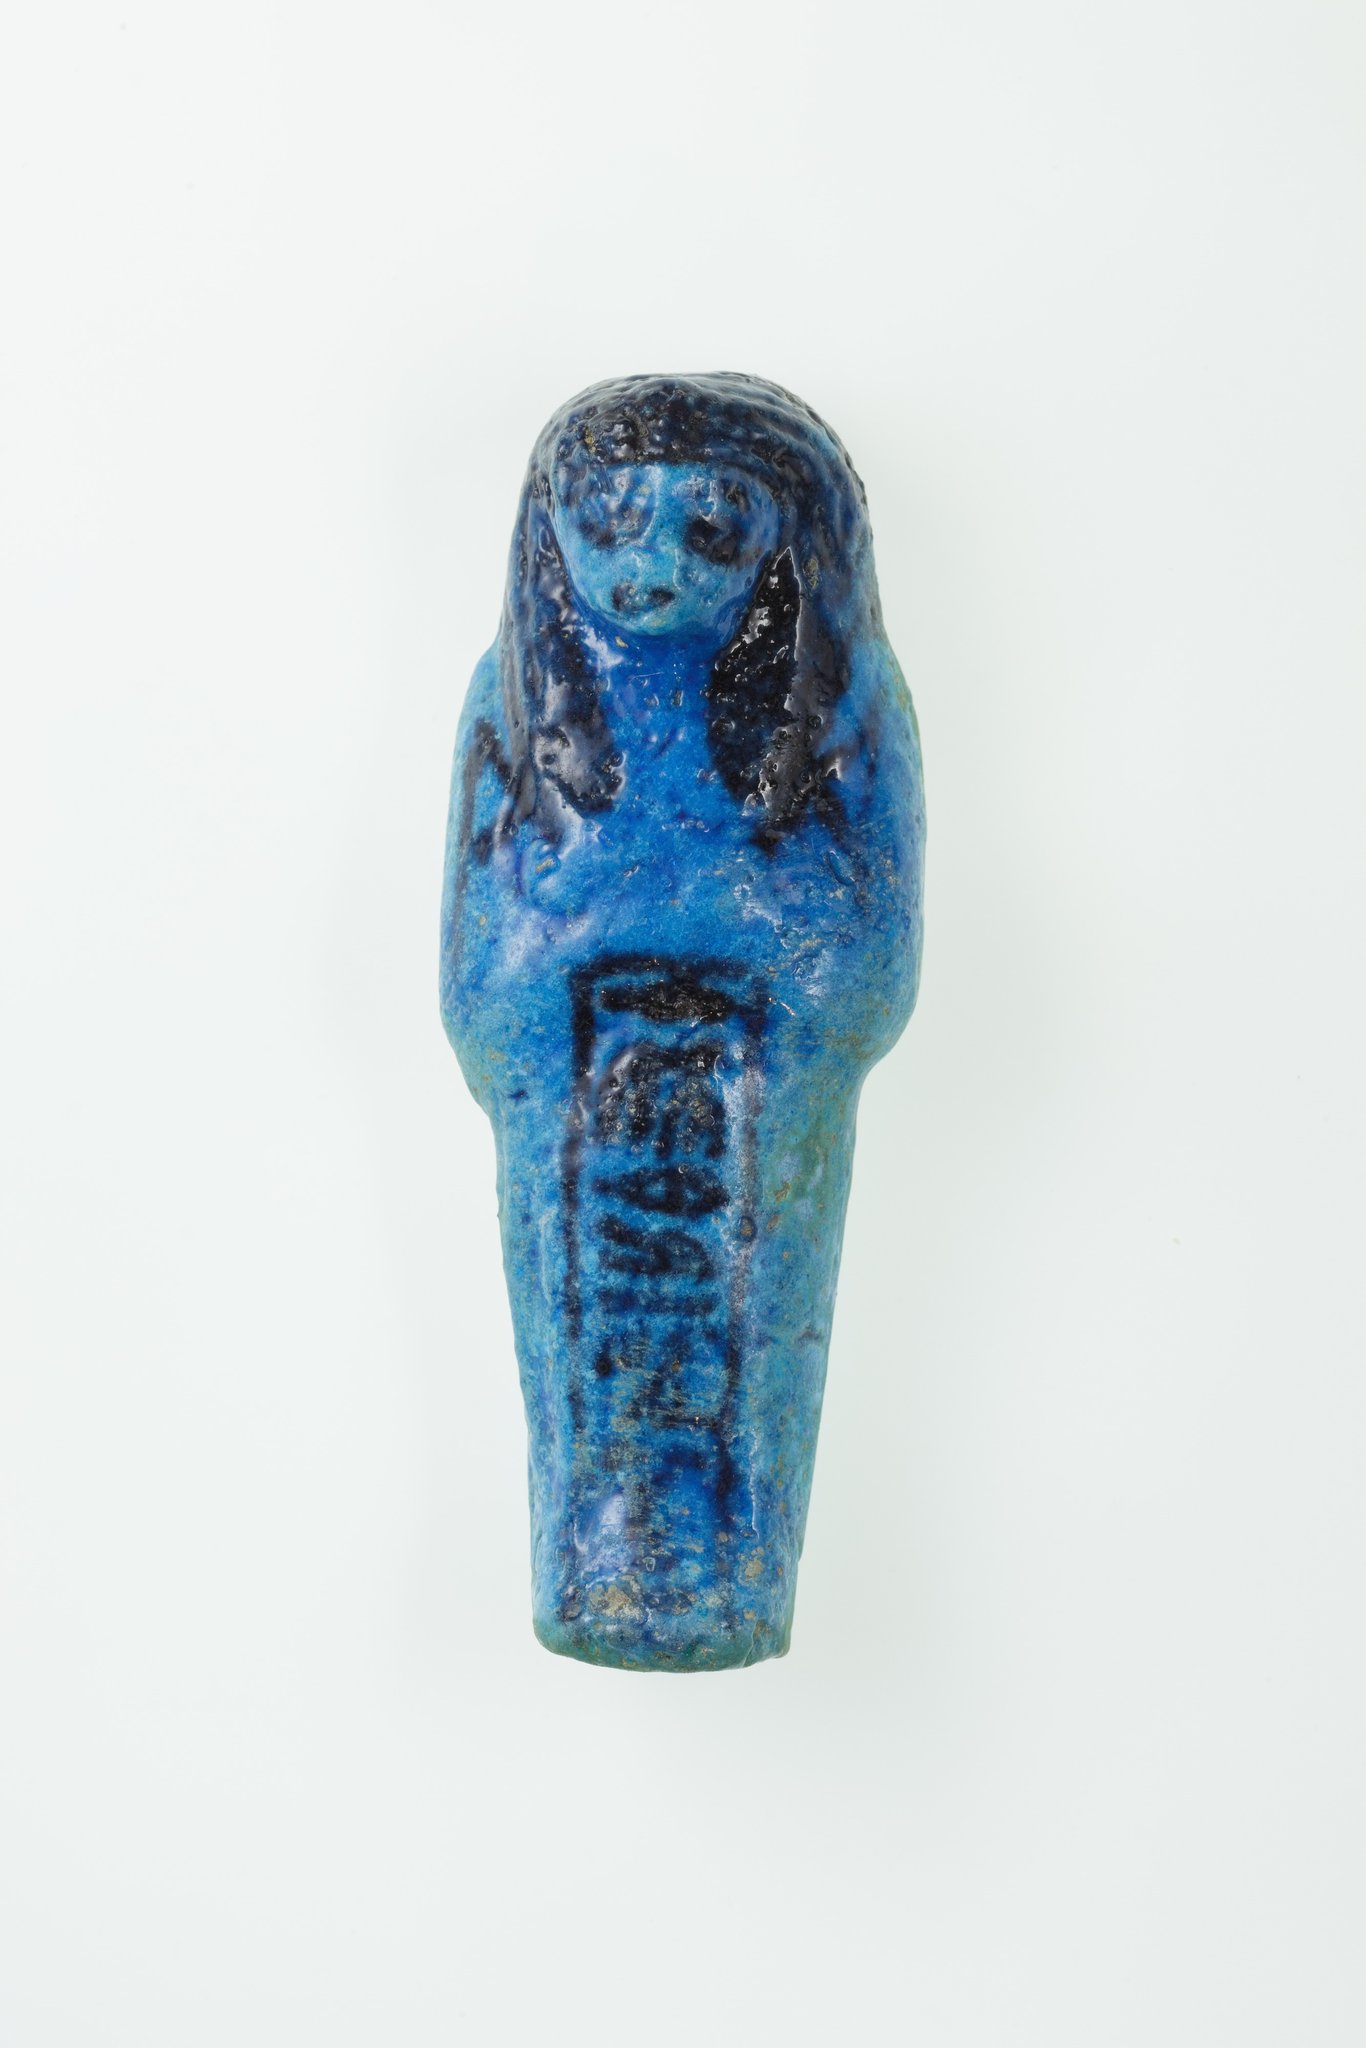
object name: shabti, worker, nauny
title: Worker Shabti of Nauny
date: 1050 BCE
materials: faience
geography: egypt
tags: hieroglyphs